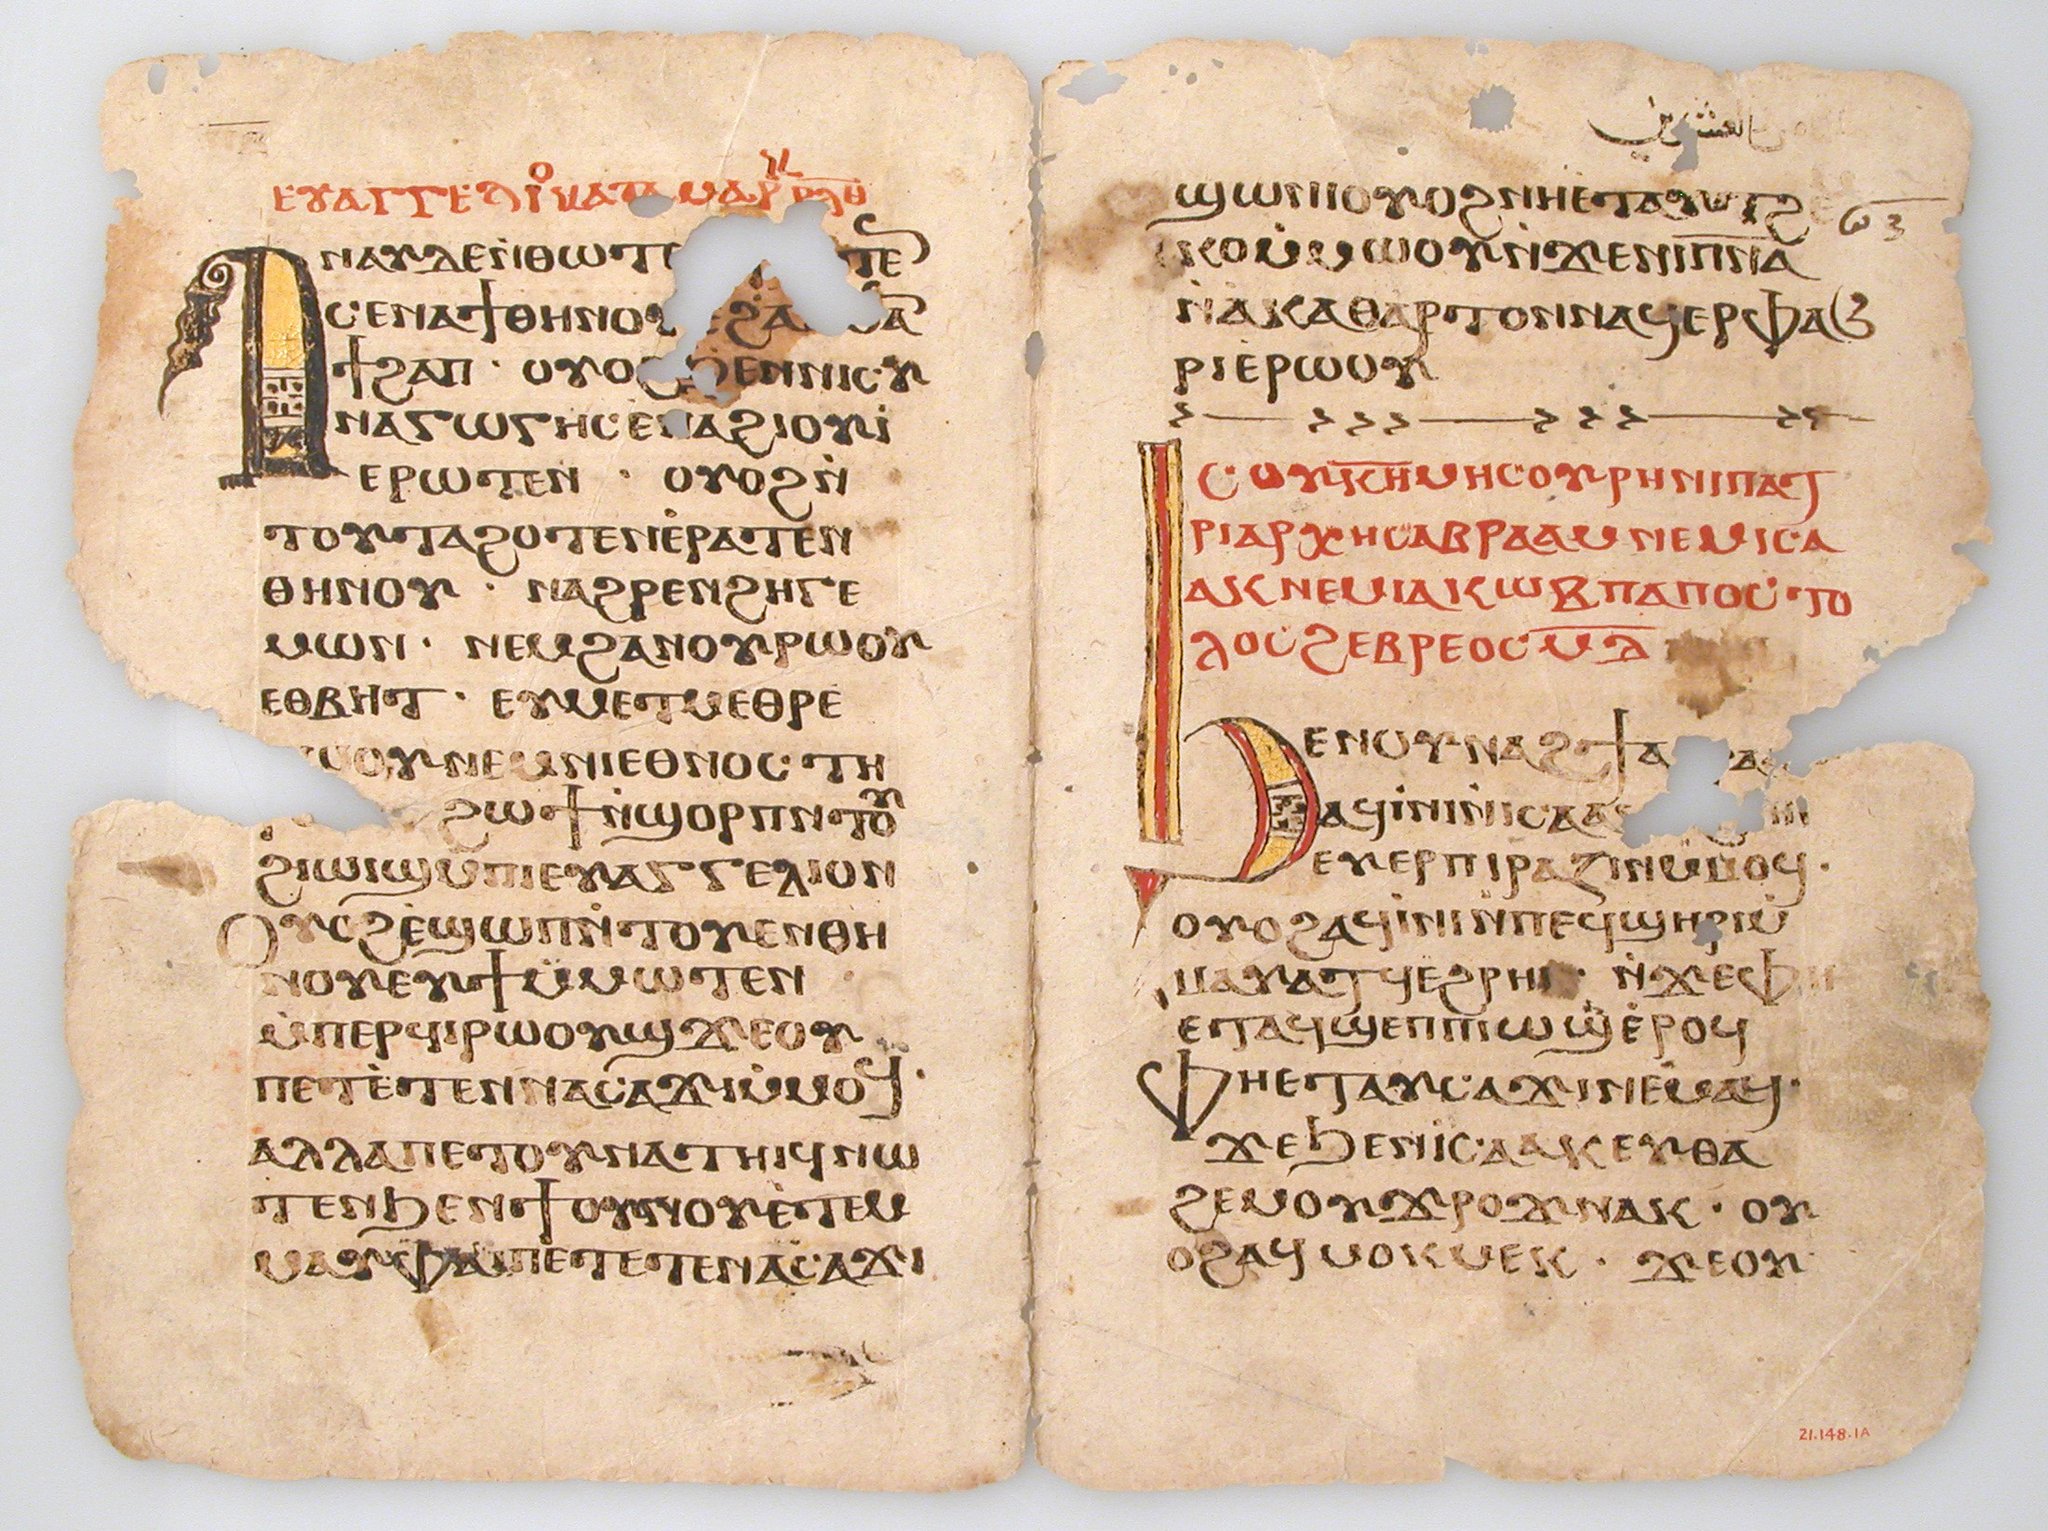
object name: manuscript leaf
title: Leaves from a Coptic Manuscript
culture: coptic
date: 501-1400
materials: ink, paper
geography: egypt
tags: coptic